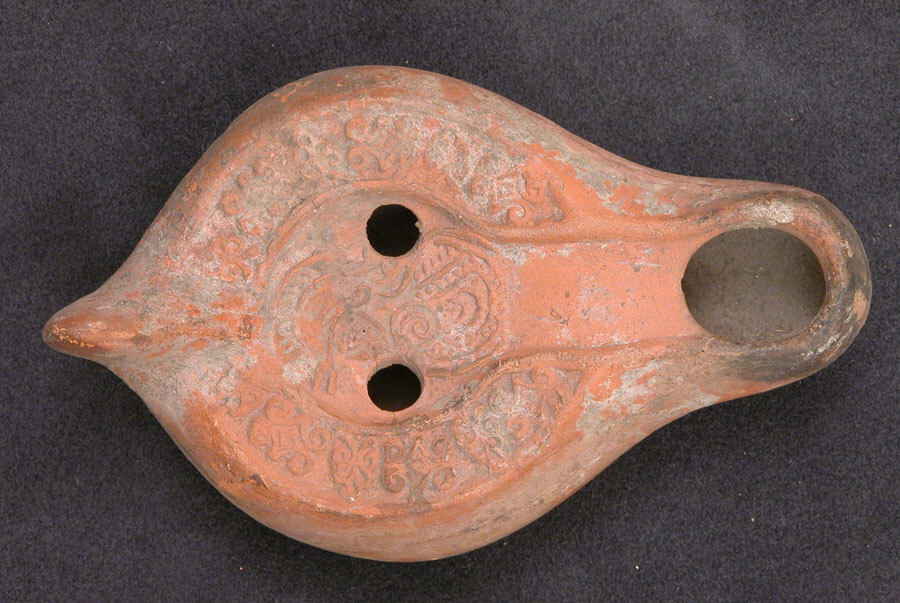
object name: lamp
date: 401-600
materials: earthenware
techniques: molding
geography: egypt